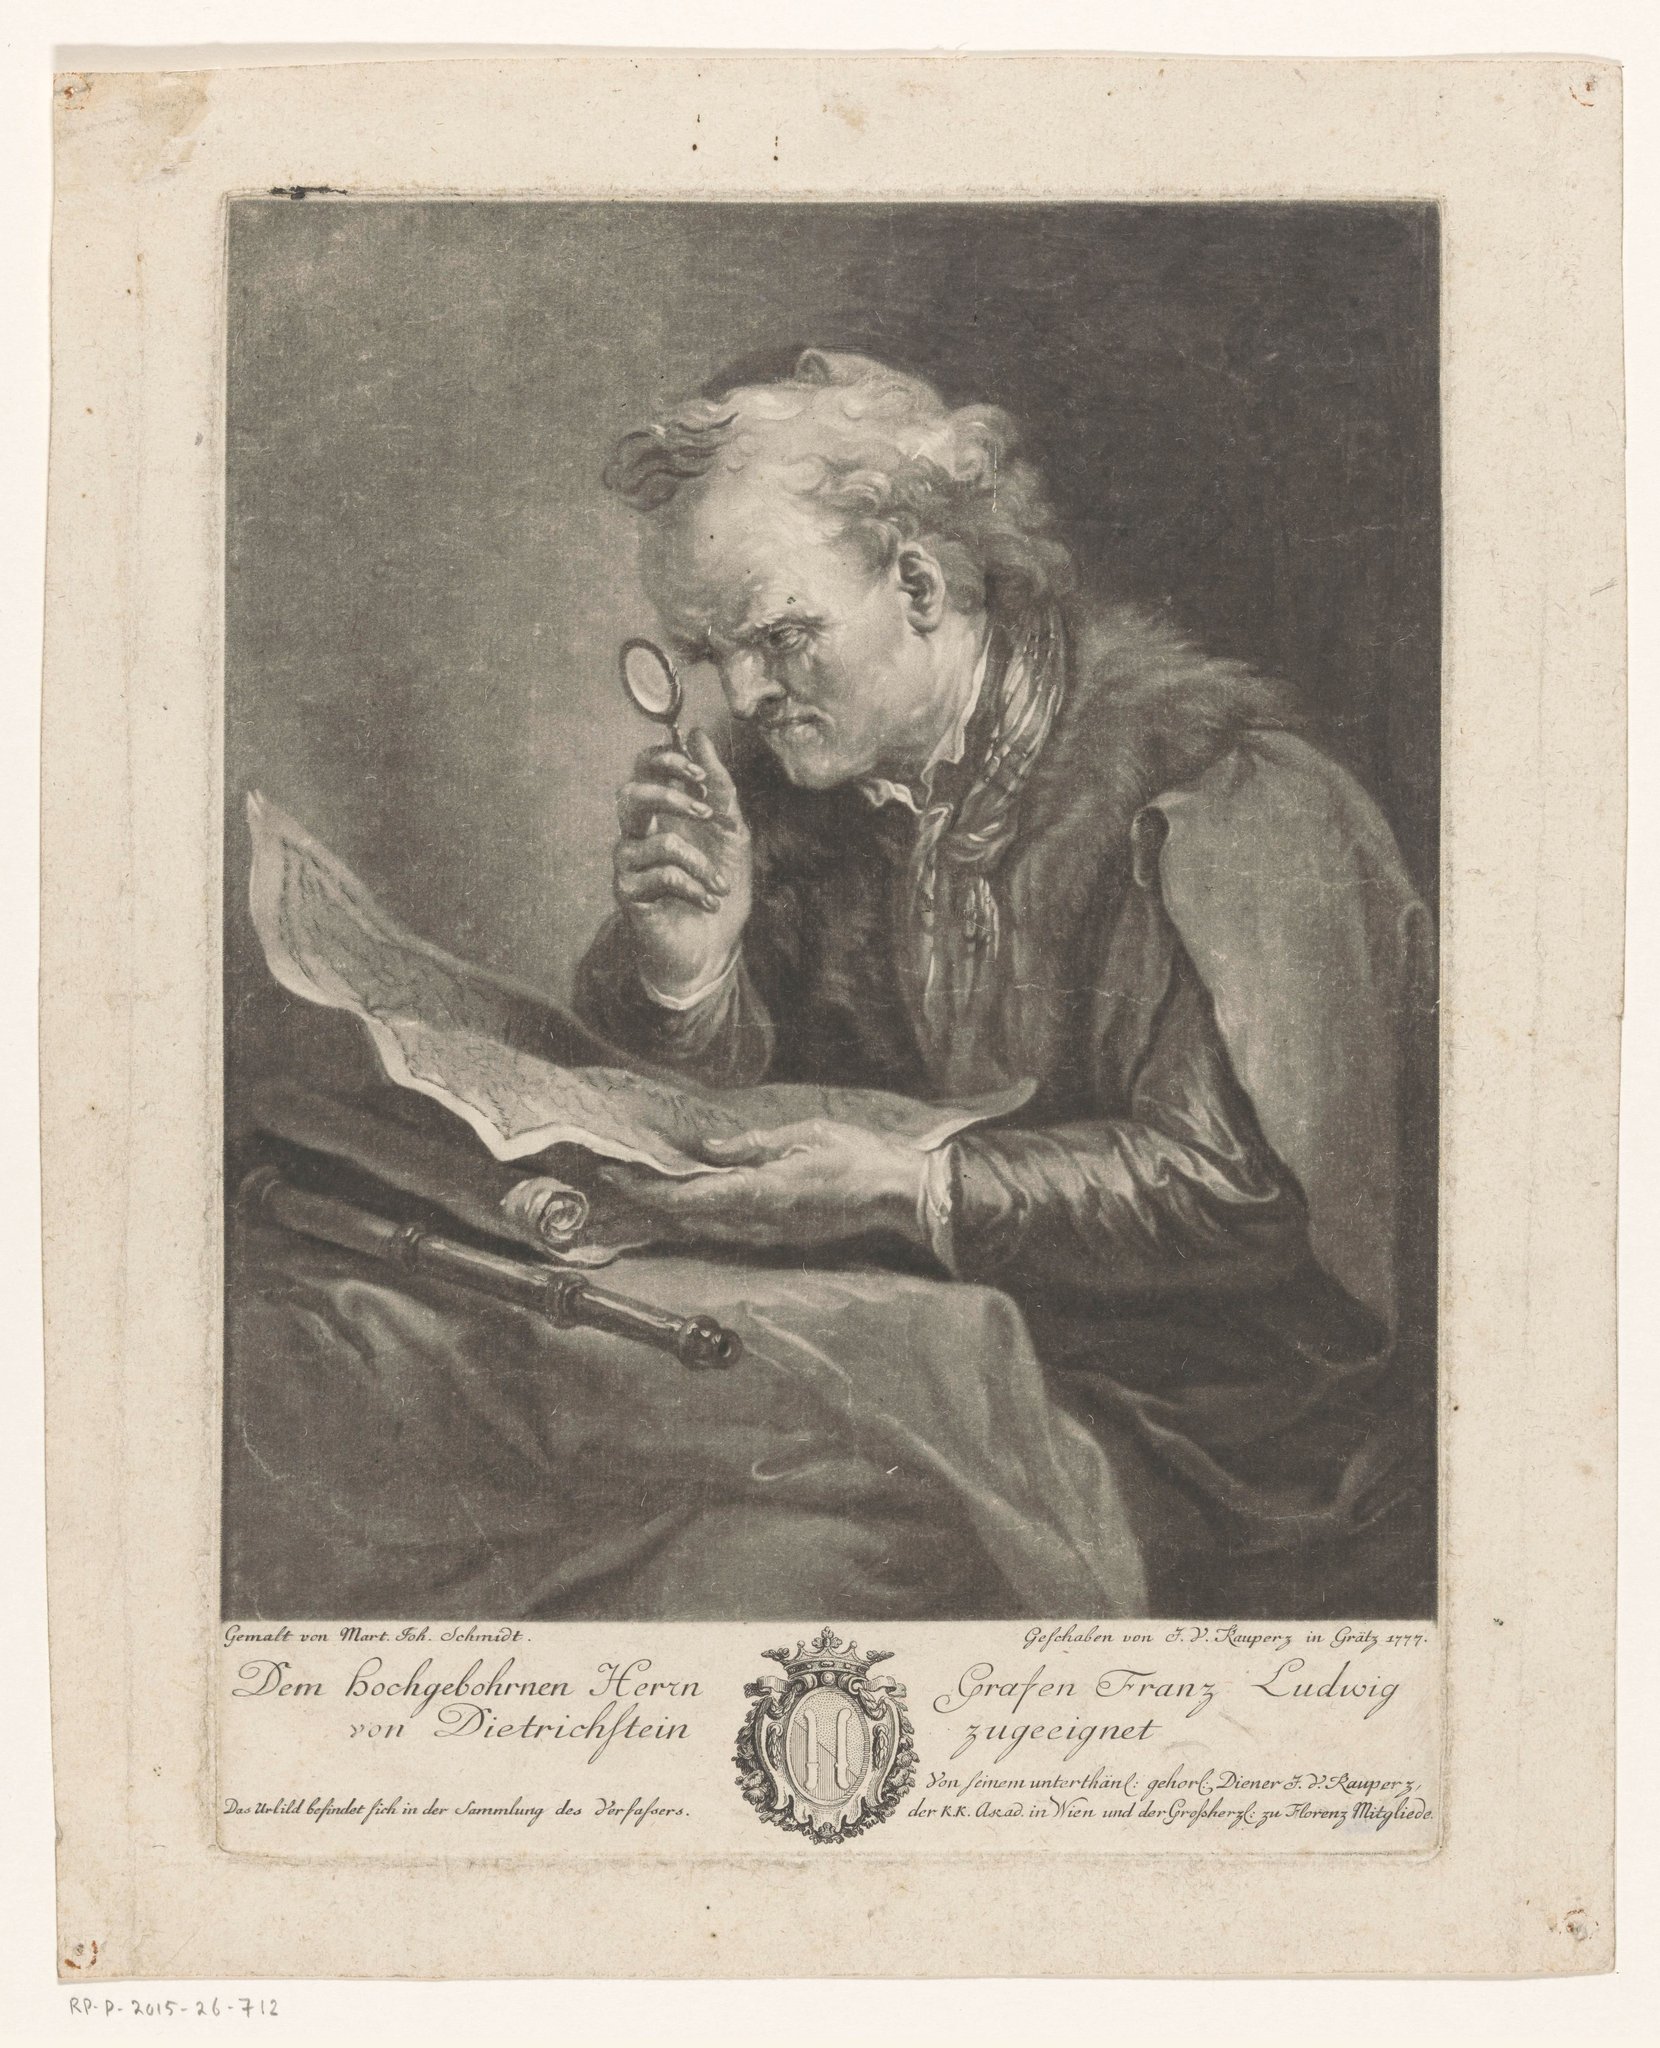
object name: print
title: Man bestudeert een kaart met een vergrootglas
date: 1777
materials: paper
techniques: mezzotint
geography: graz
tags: telescope, studying a map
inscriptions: collector's mark: Lugt 2228, collector's mark: Lugt 4780, collector's mark: Lugt 4779, collector's mark: ‘Oswald Stein’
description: De man zit achter een tafel, op de rand ligt een telescoop. Met onderschrift in het Duits en het wapen van Franz Ludwig von Dietrichstein.